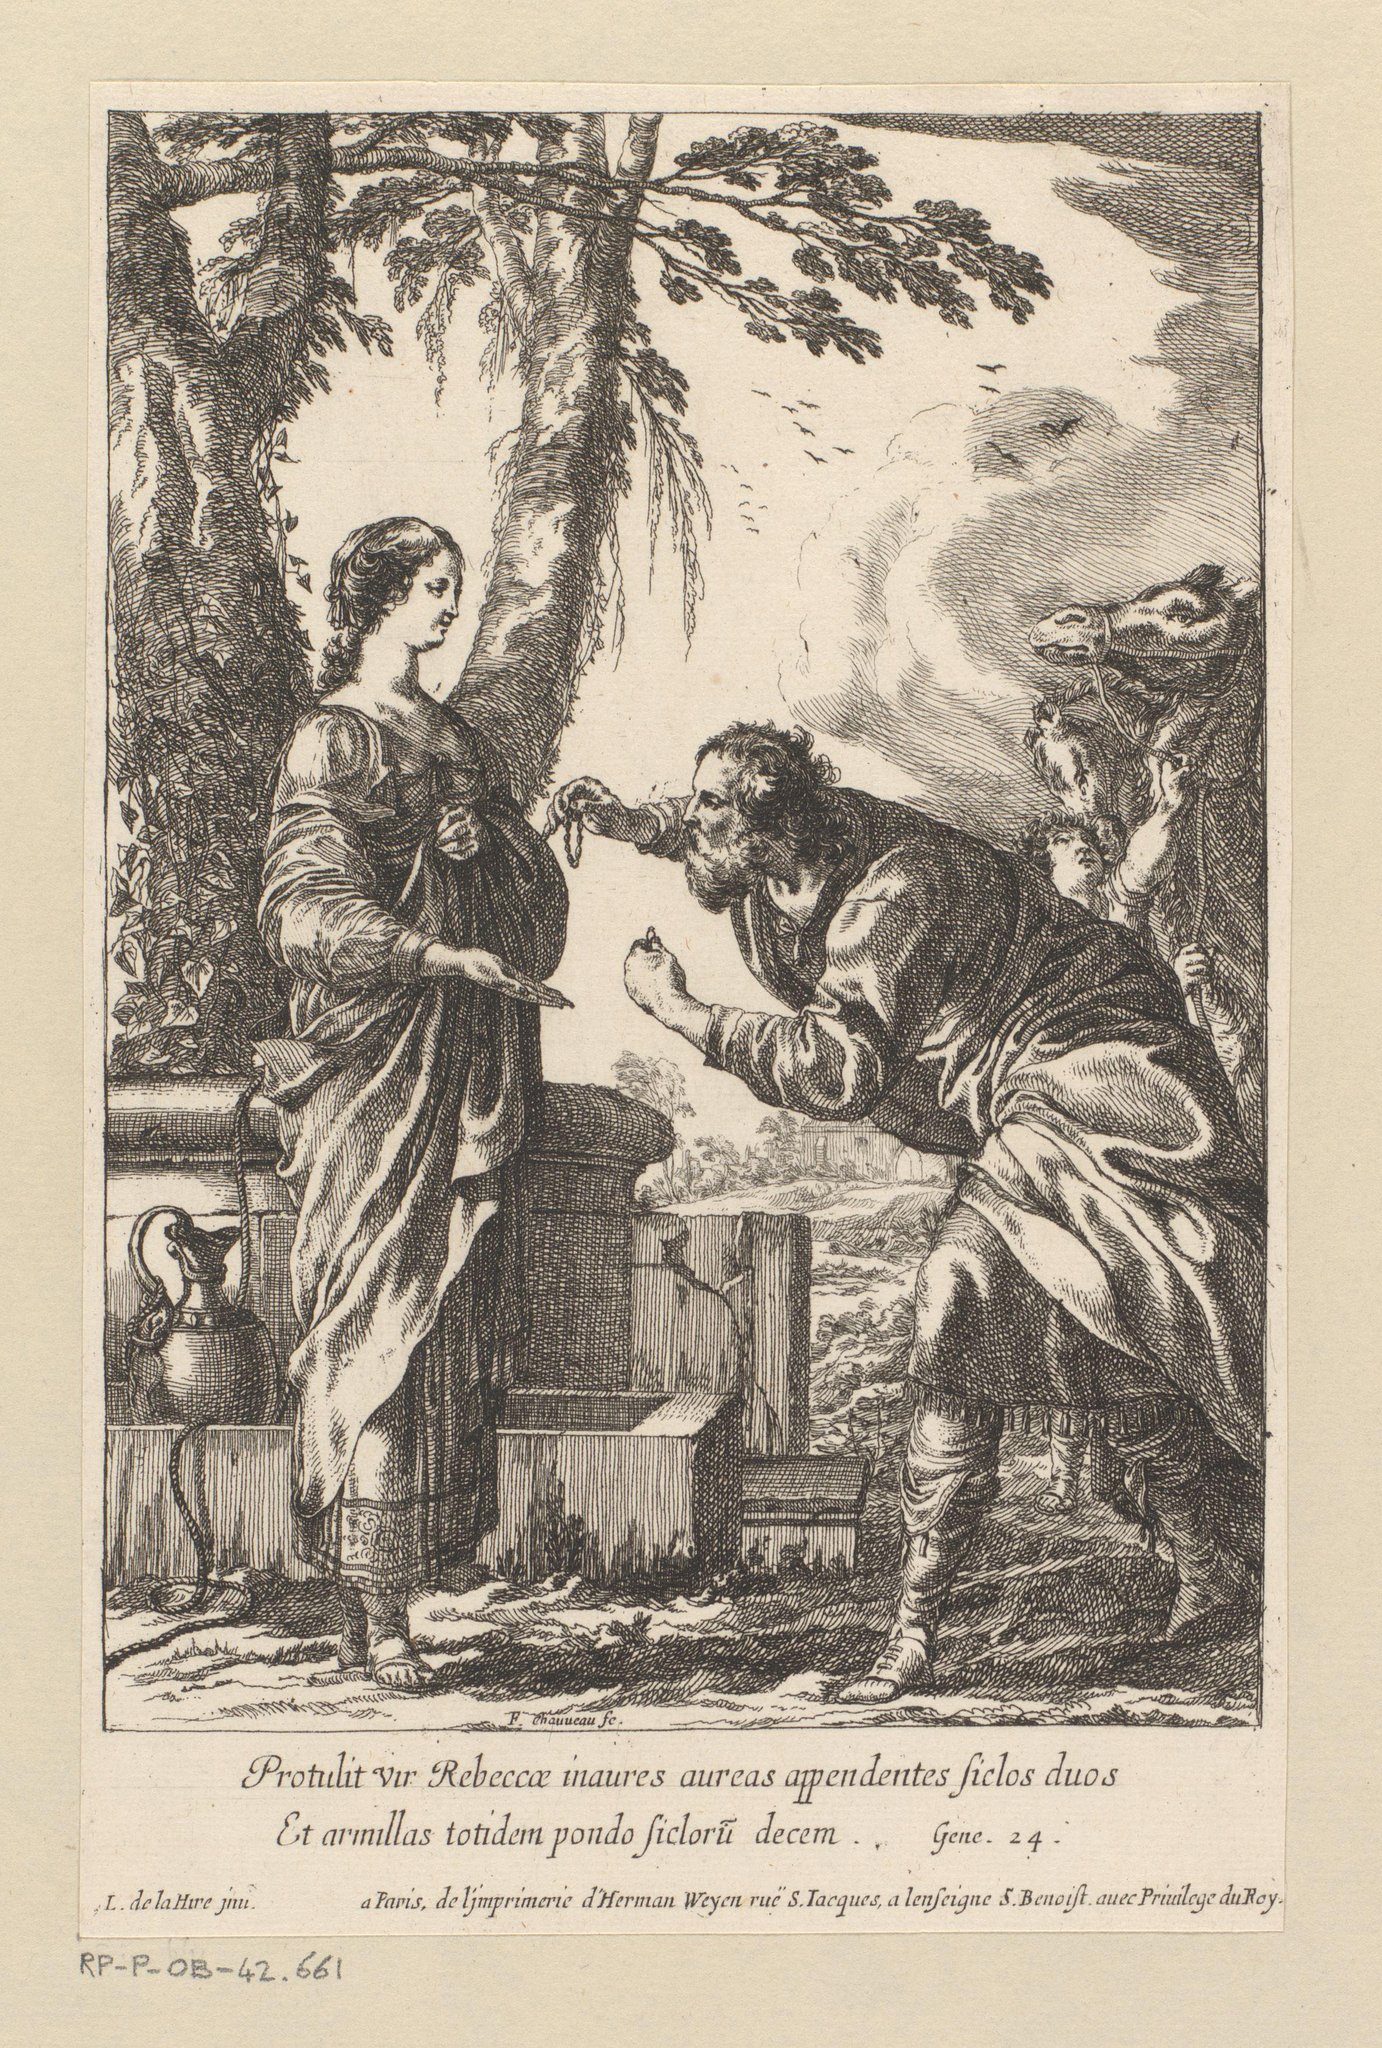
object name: print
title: Rebekka en Eliëzer bij de bron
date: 1623-1672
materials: paper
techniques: etching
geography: paris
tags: hoofed animals: camel, the meeting at the well: eliezer sees rebekah coming with a pitcher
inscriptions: collector's mark: Lugt 240